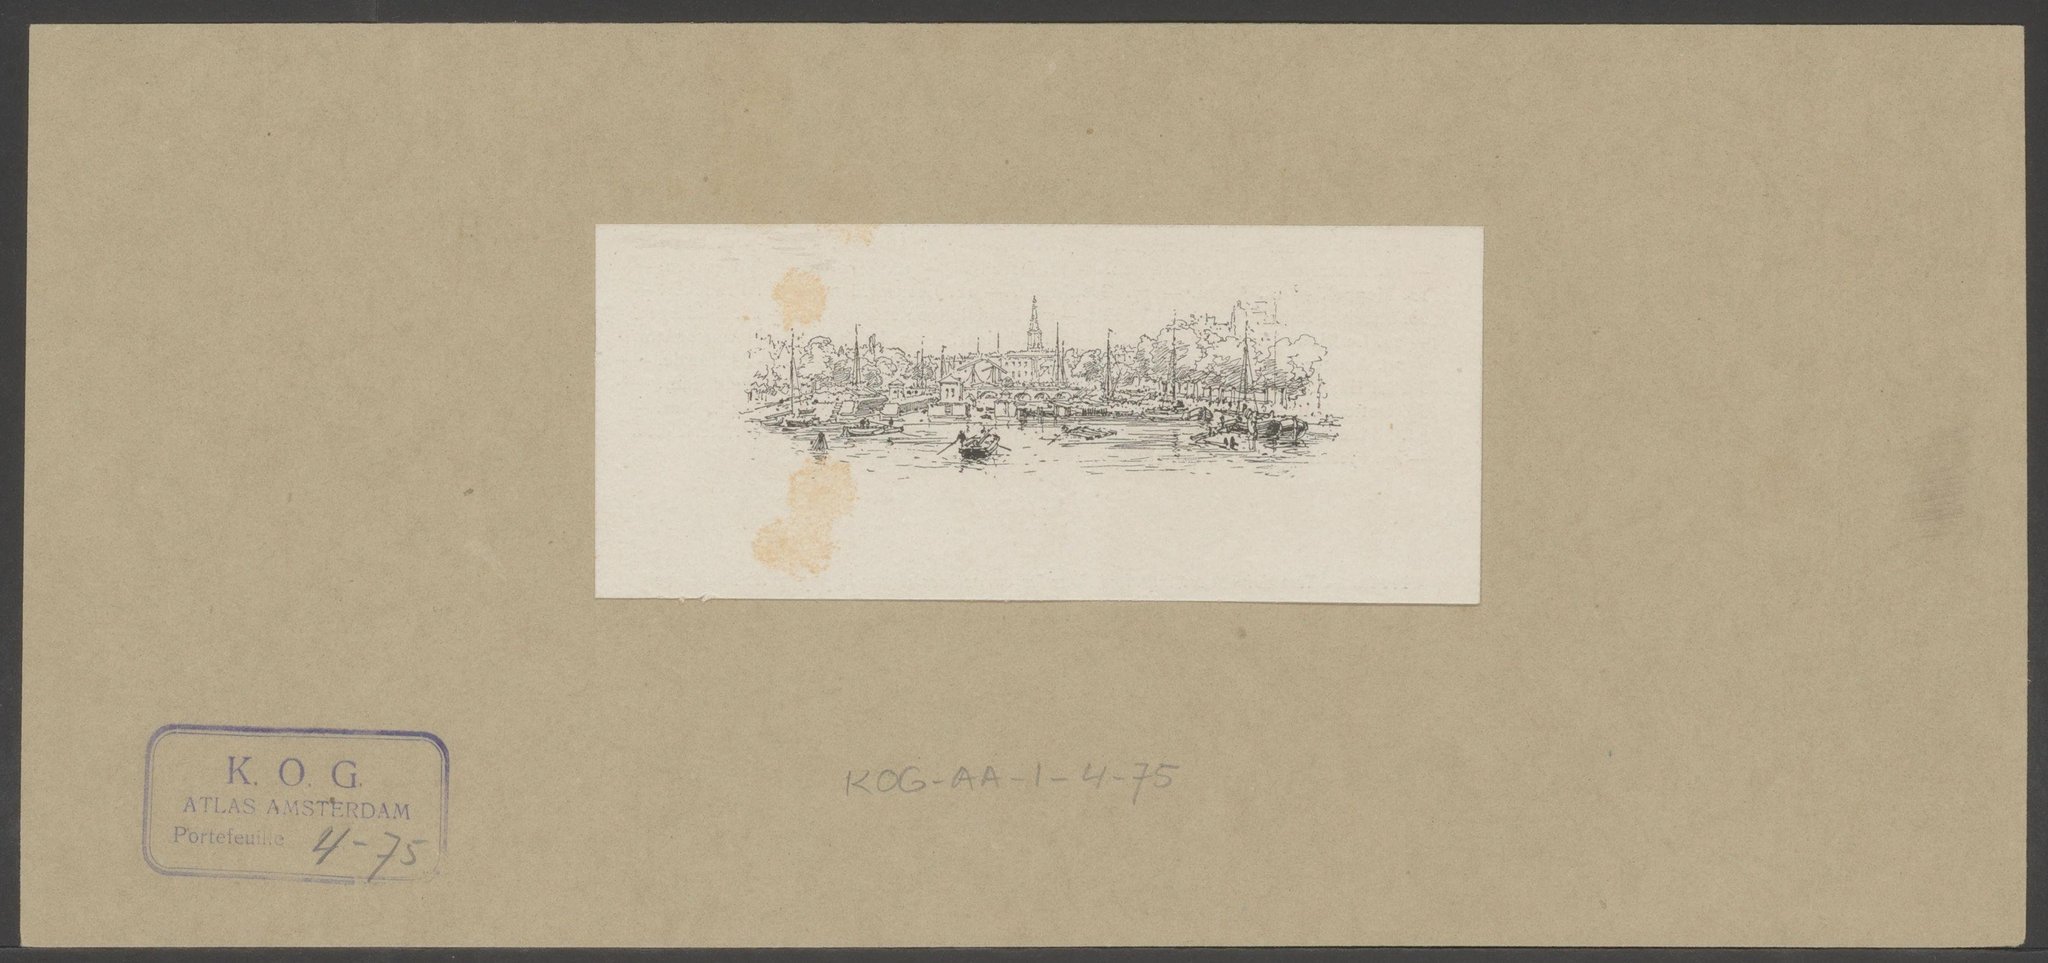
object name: book illustration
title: Gezicht op de Binnen-Amstel en de Amstelsluizen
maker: Anonymous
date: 1800-1899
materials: paper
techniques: letterpress printing, line block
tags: sluice, weir, city-view in general; 'veduta', canal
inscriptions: collector's mark: ‘4-75’ Lugt 1641b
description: Onderwerpsrubriek binnen de Atlas Amsterdam: Amstel van Blauwbrug tot Hogesluis.